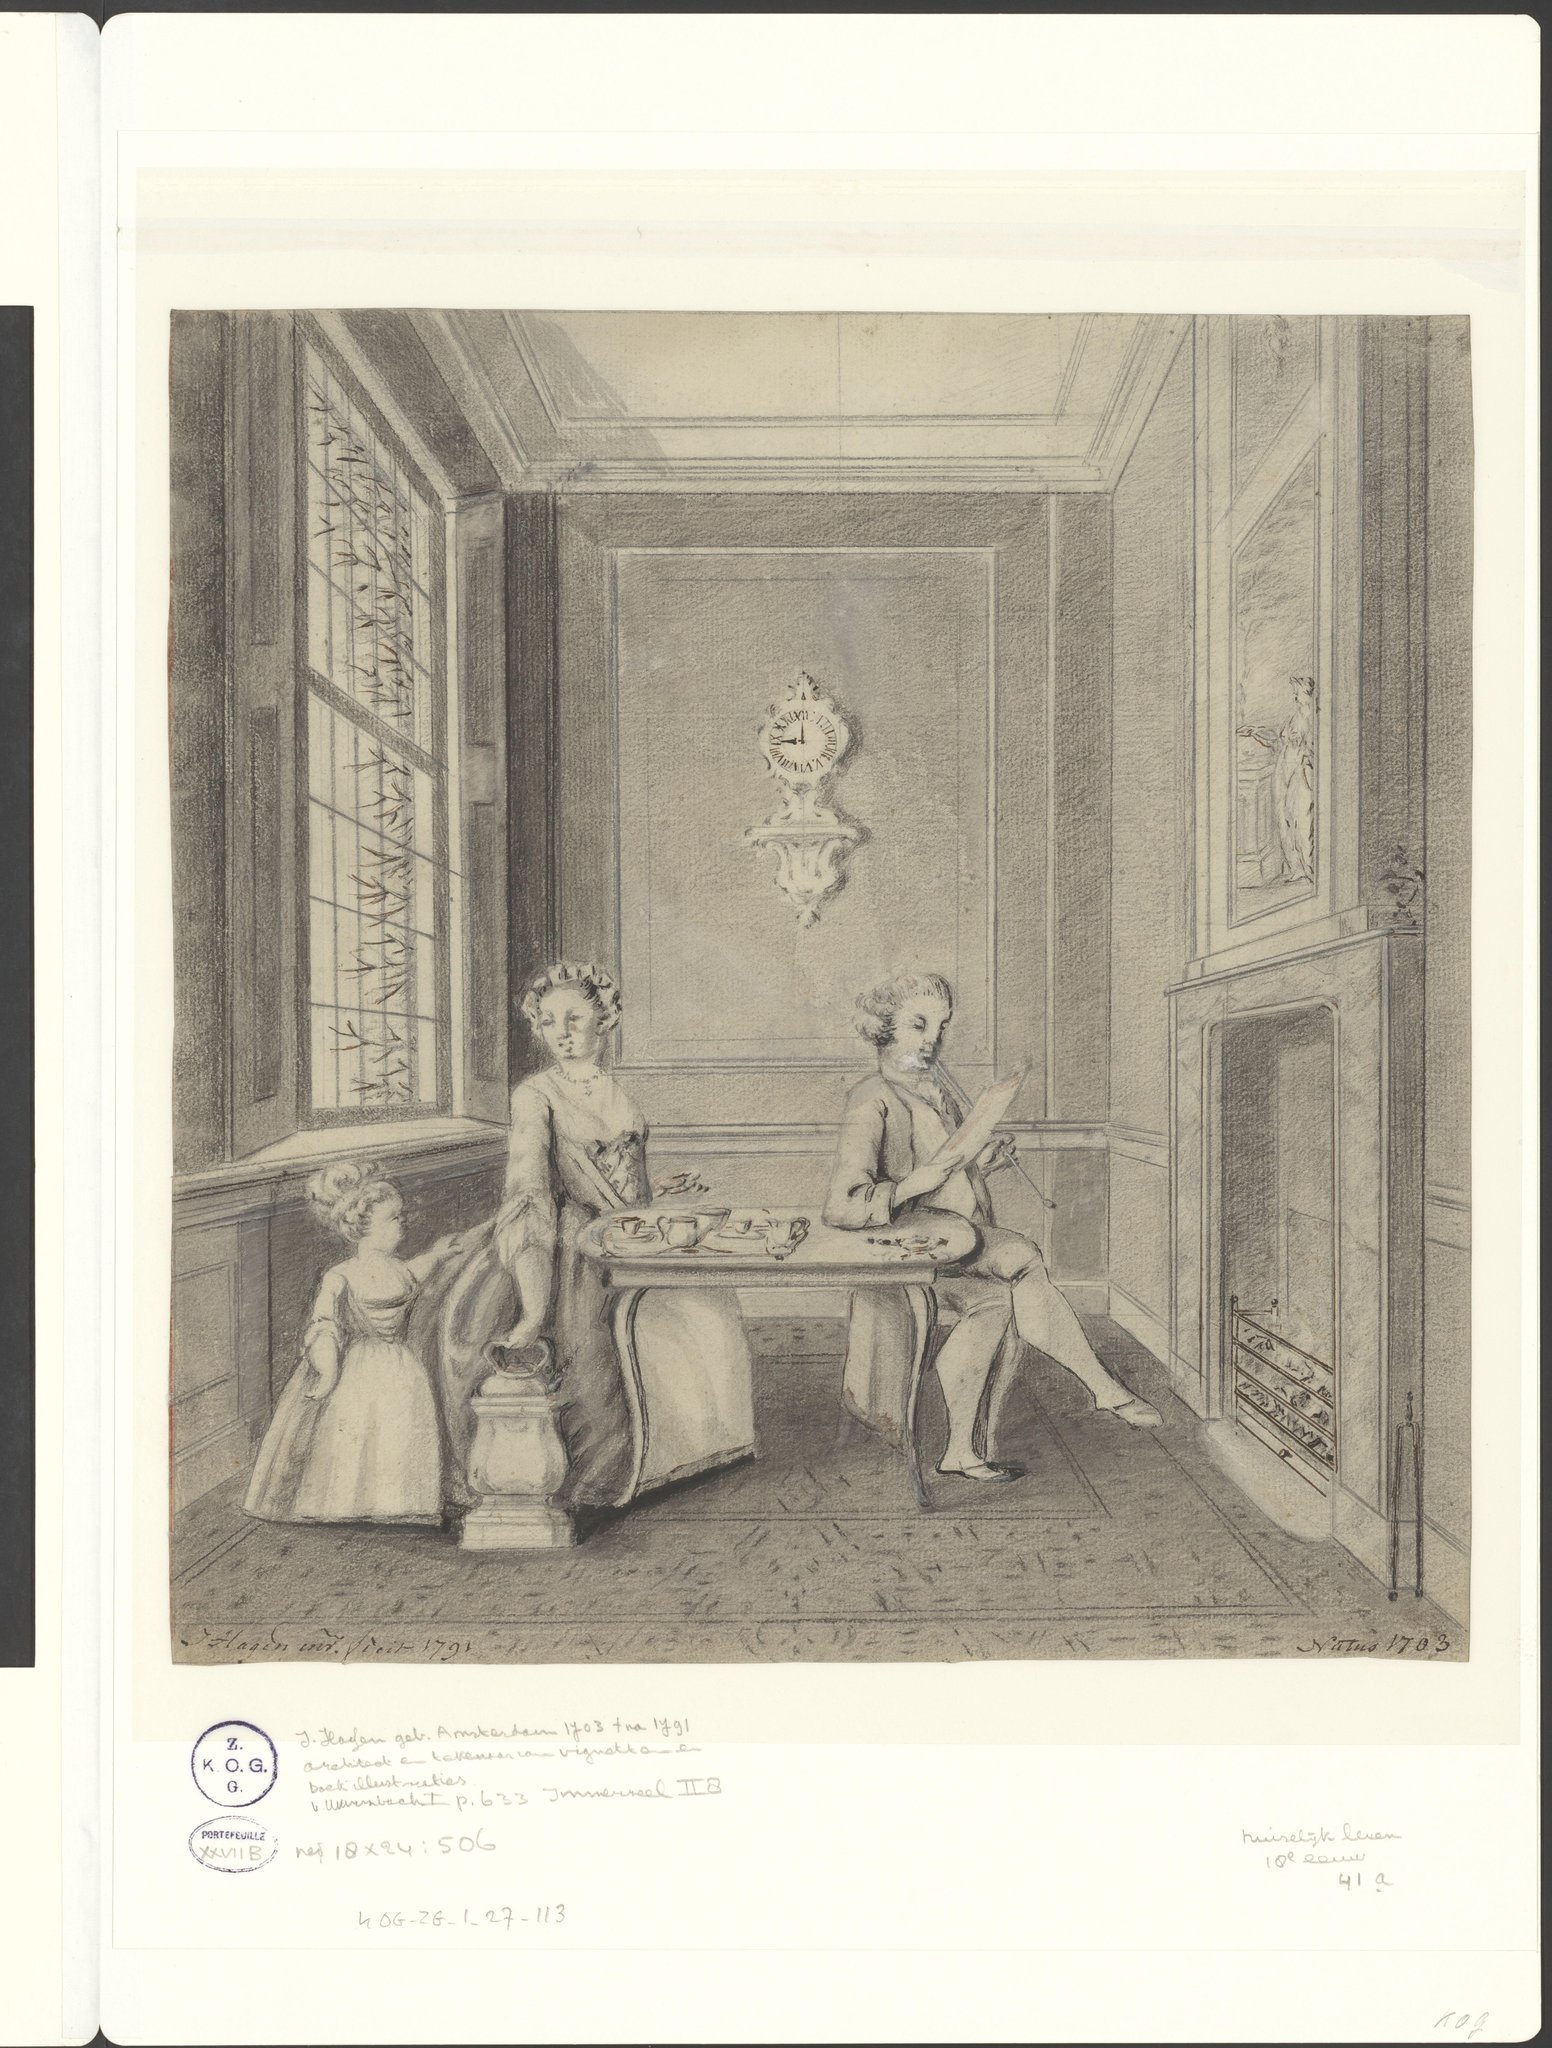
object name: drawing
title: Huiselijke taferelen door Jacob Hagen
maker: jacob hagen (ii)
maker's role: draughtsman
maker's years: 1703-1791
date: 1791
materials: chalk, ink, paper, pencil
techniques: brush, pen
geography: netherlands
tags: reading, pipe ~ tobacco, clock, communal rooms, family life at home, tea- and coffee-service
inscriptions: collector's mark, collector's mark: Lugt 1641